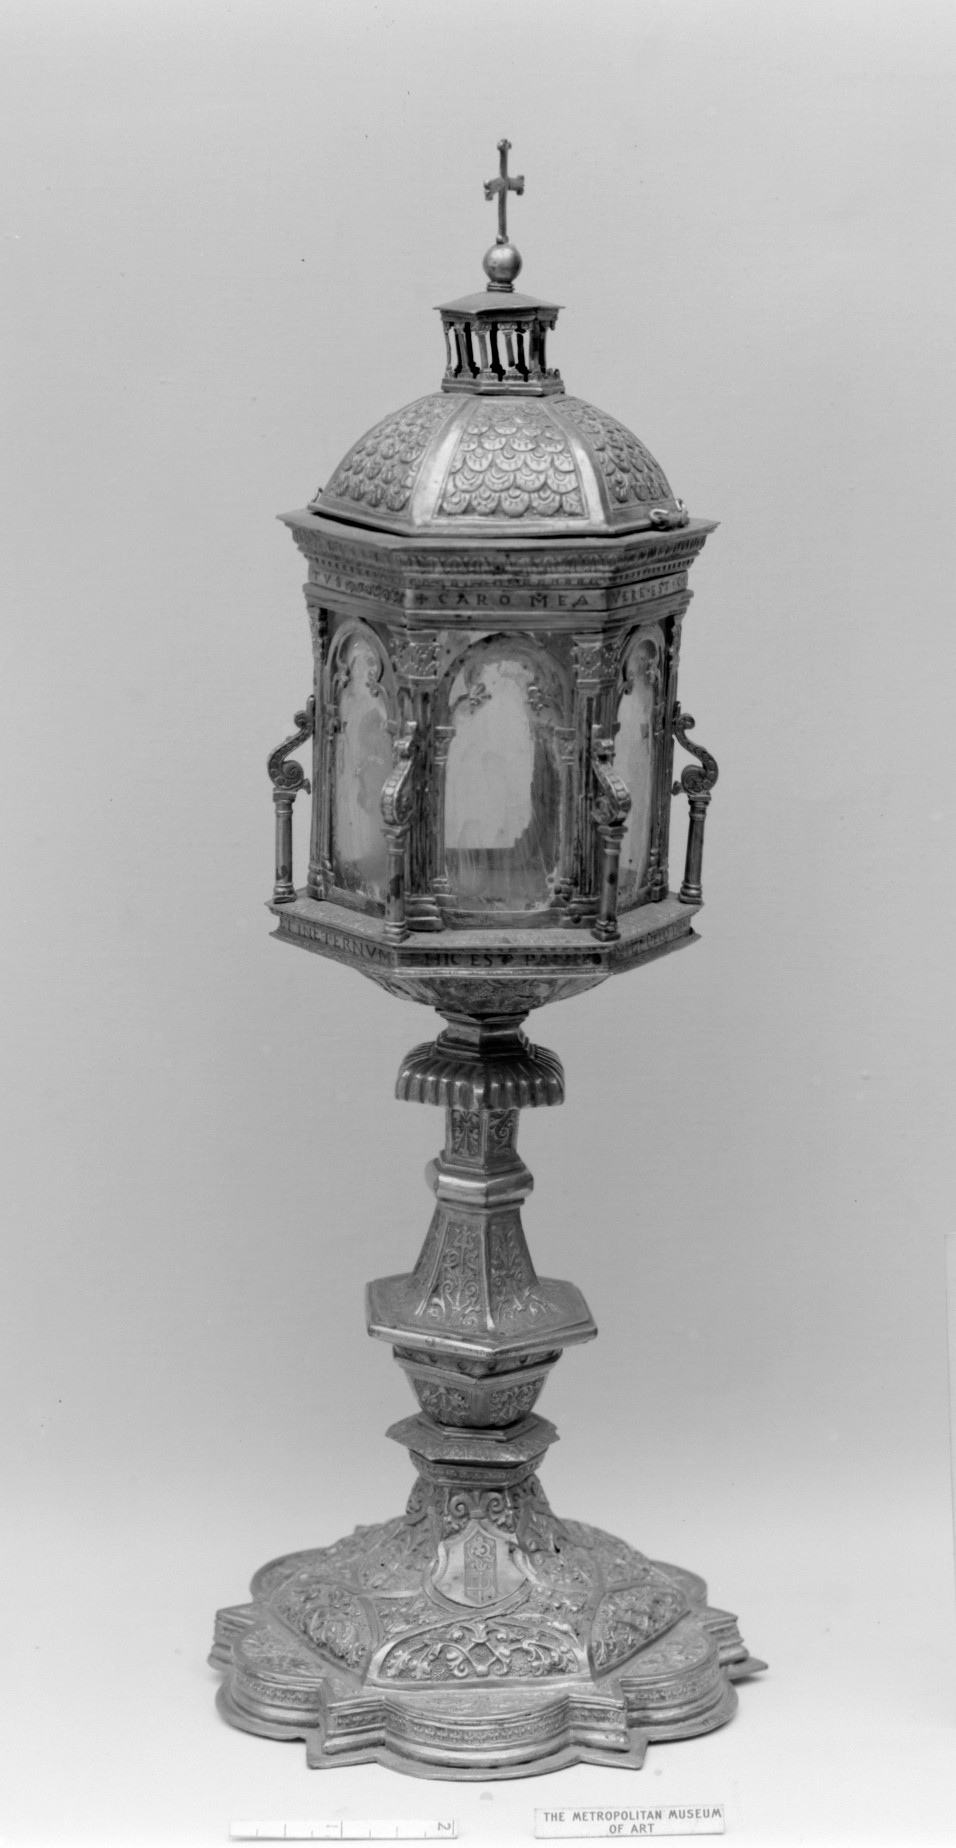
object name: monstrance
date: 1551-1575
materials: copper gilt, glass, niello, silver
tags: birds,dogs,horses